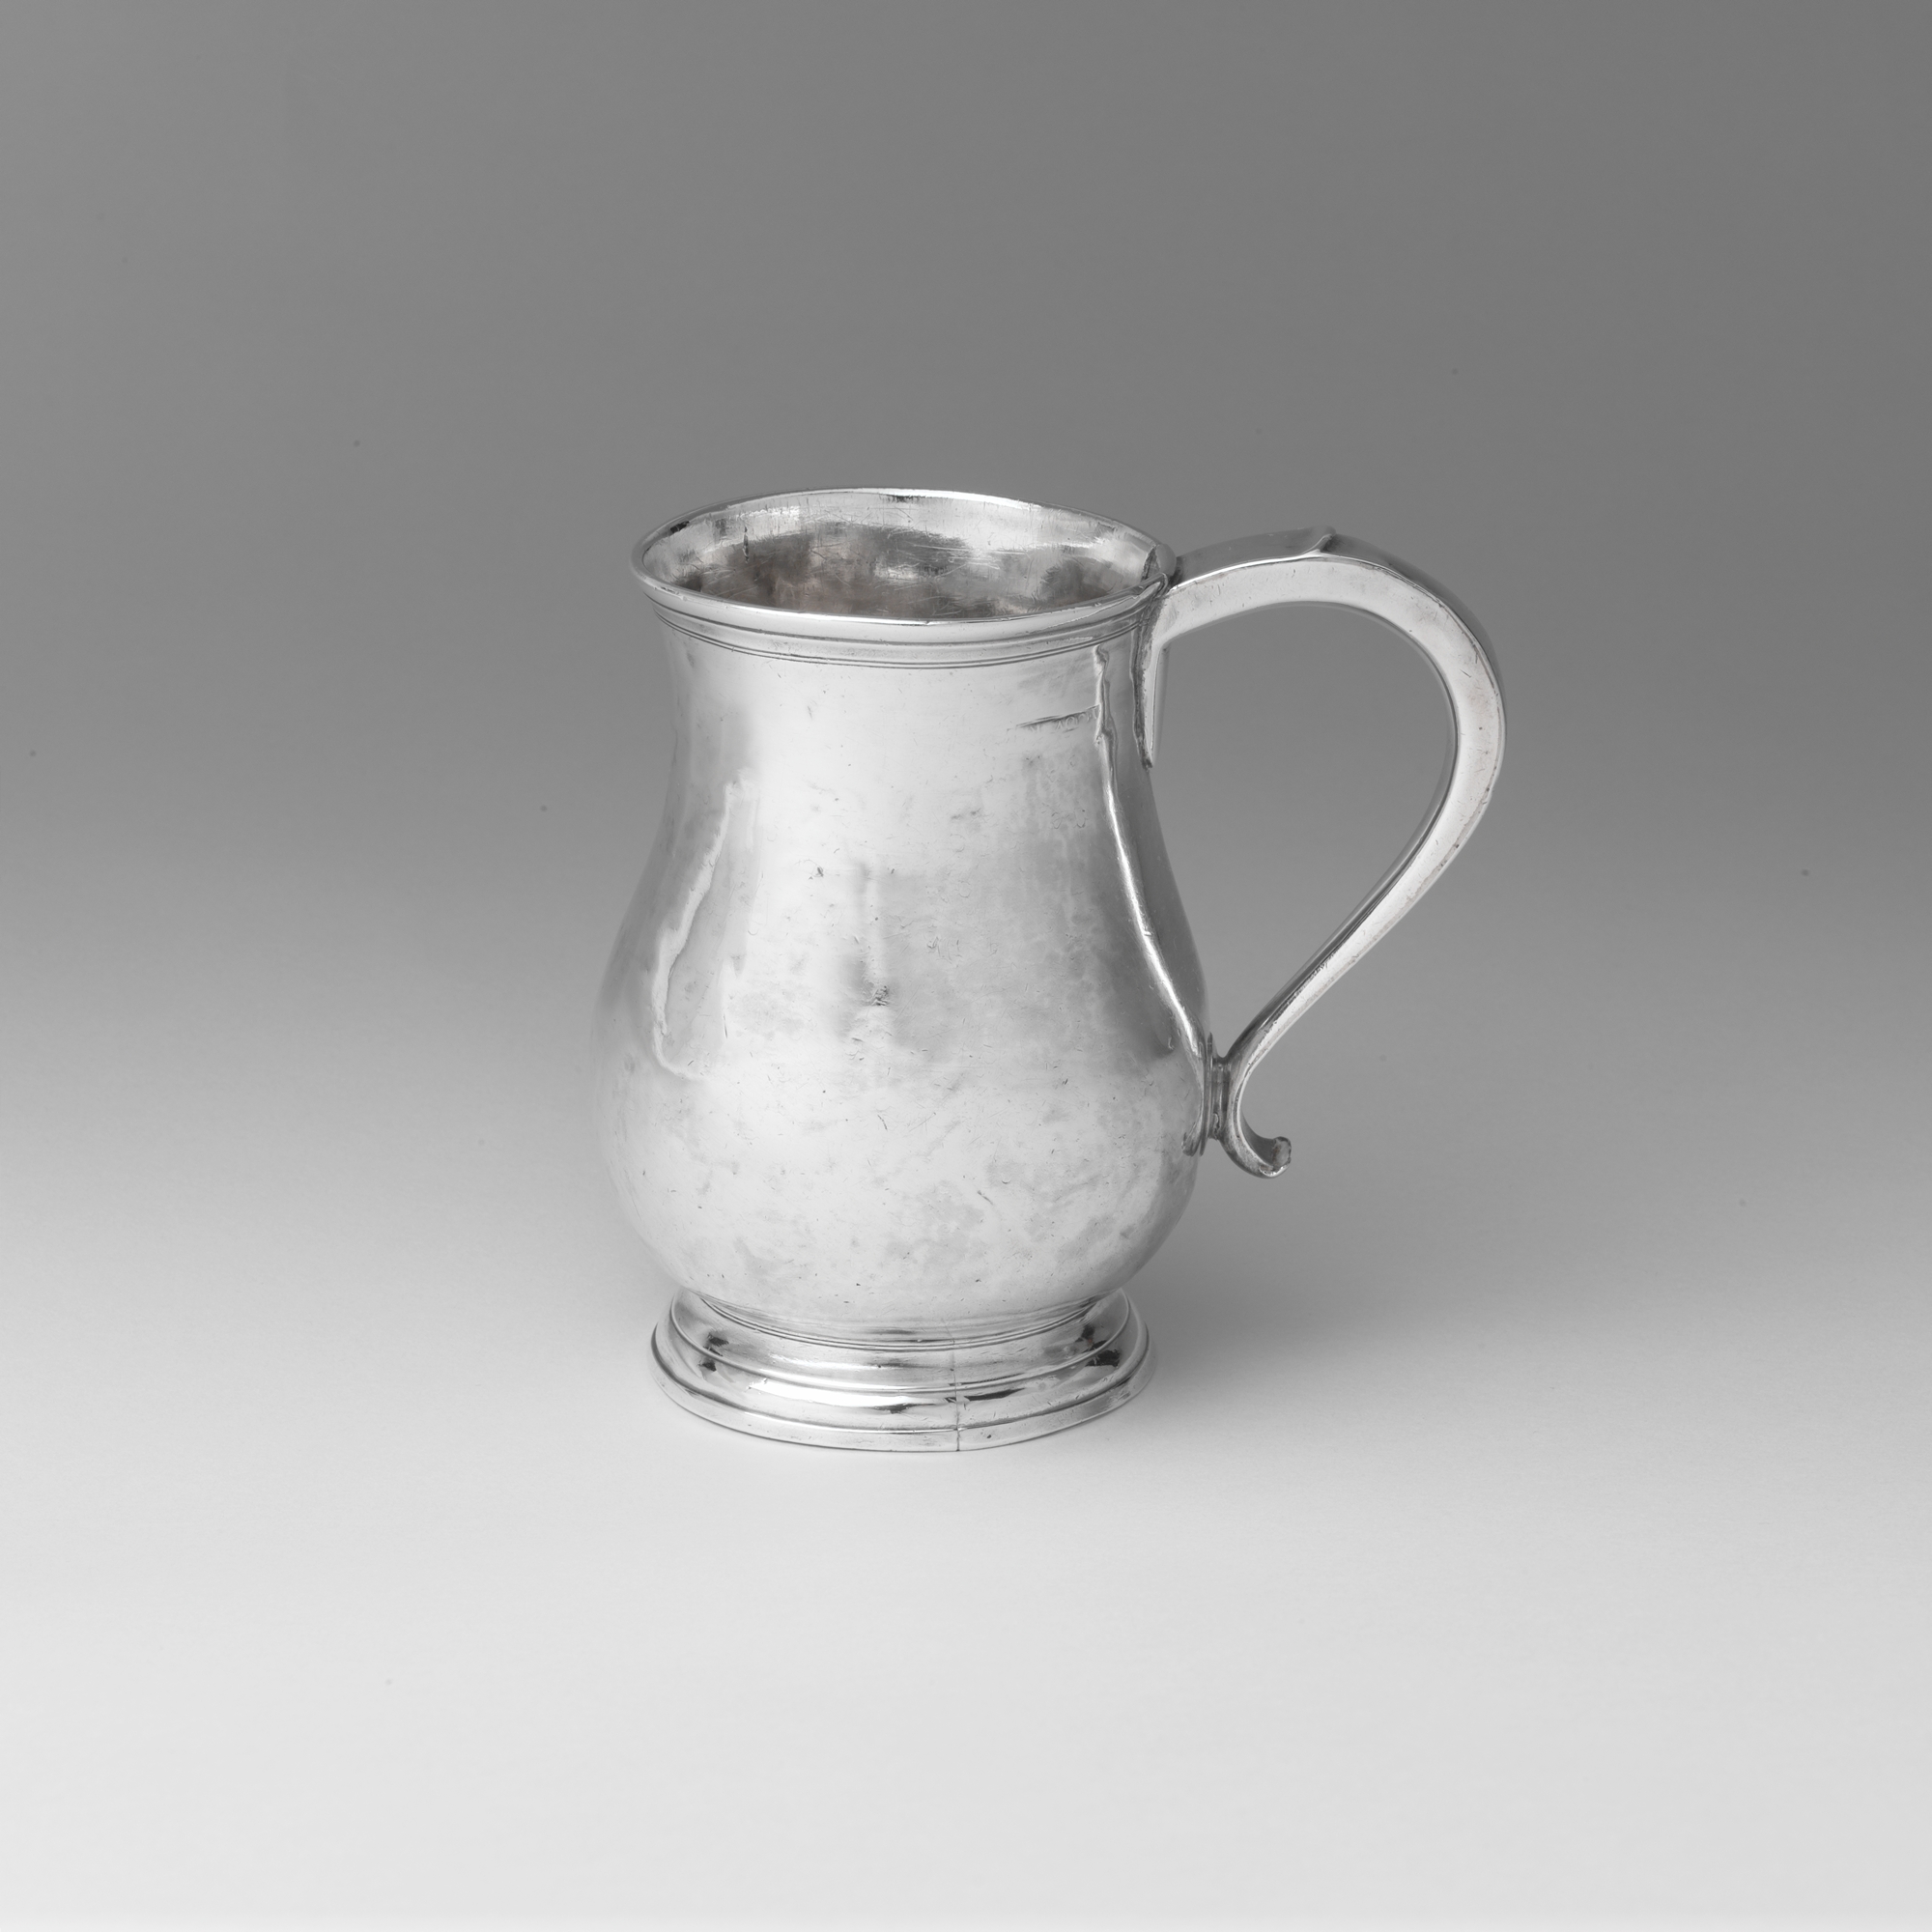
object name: cann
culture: american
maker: john coverly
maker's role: maker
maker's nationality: american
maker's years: 1713-1783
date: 1750-1760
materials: silver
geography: united states